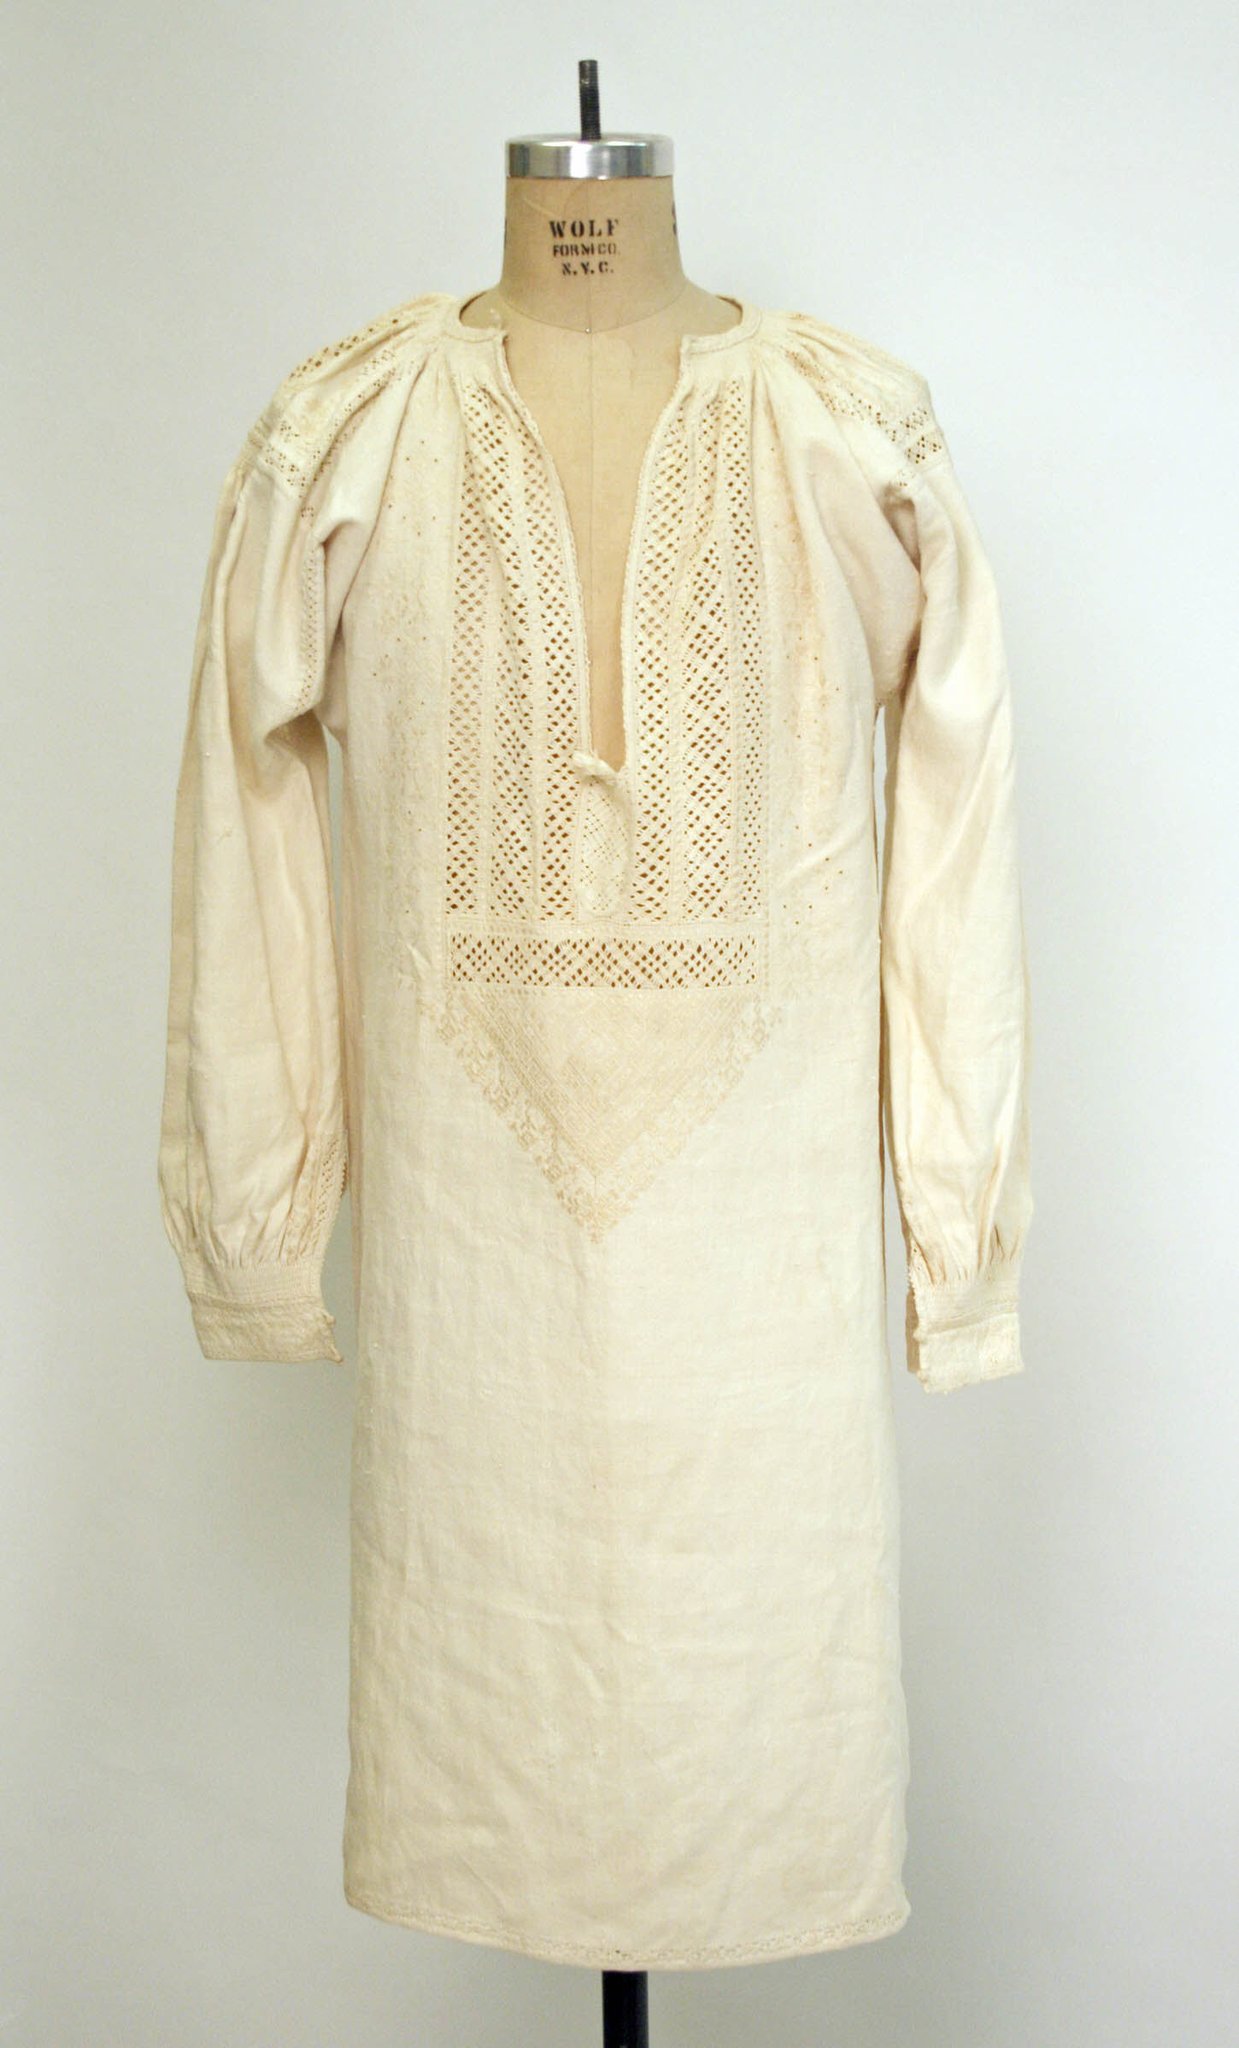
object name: wedding ensemble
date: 1701-1800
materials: linen